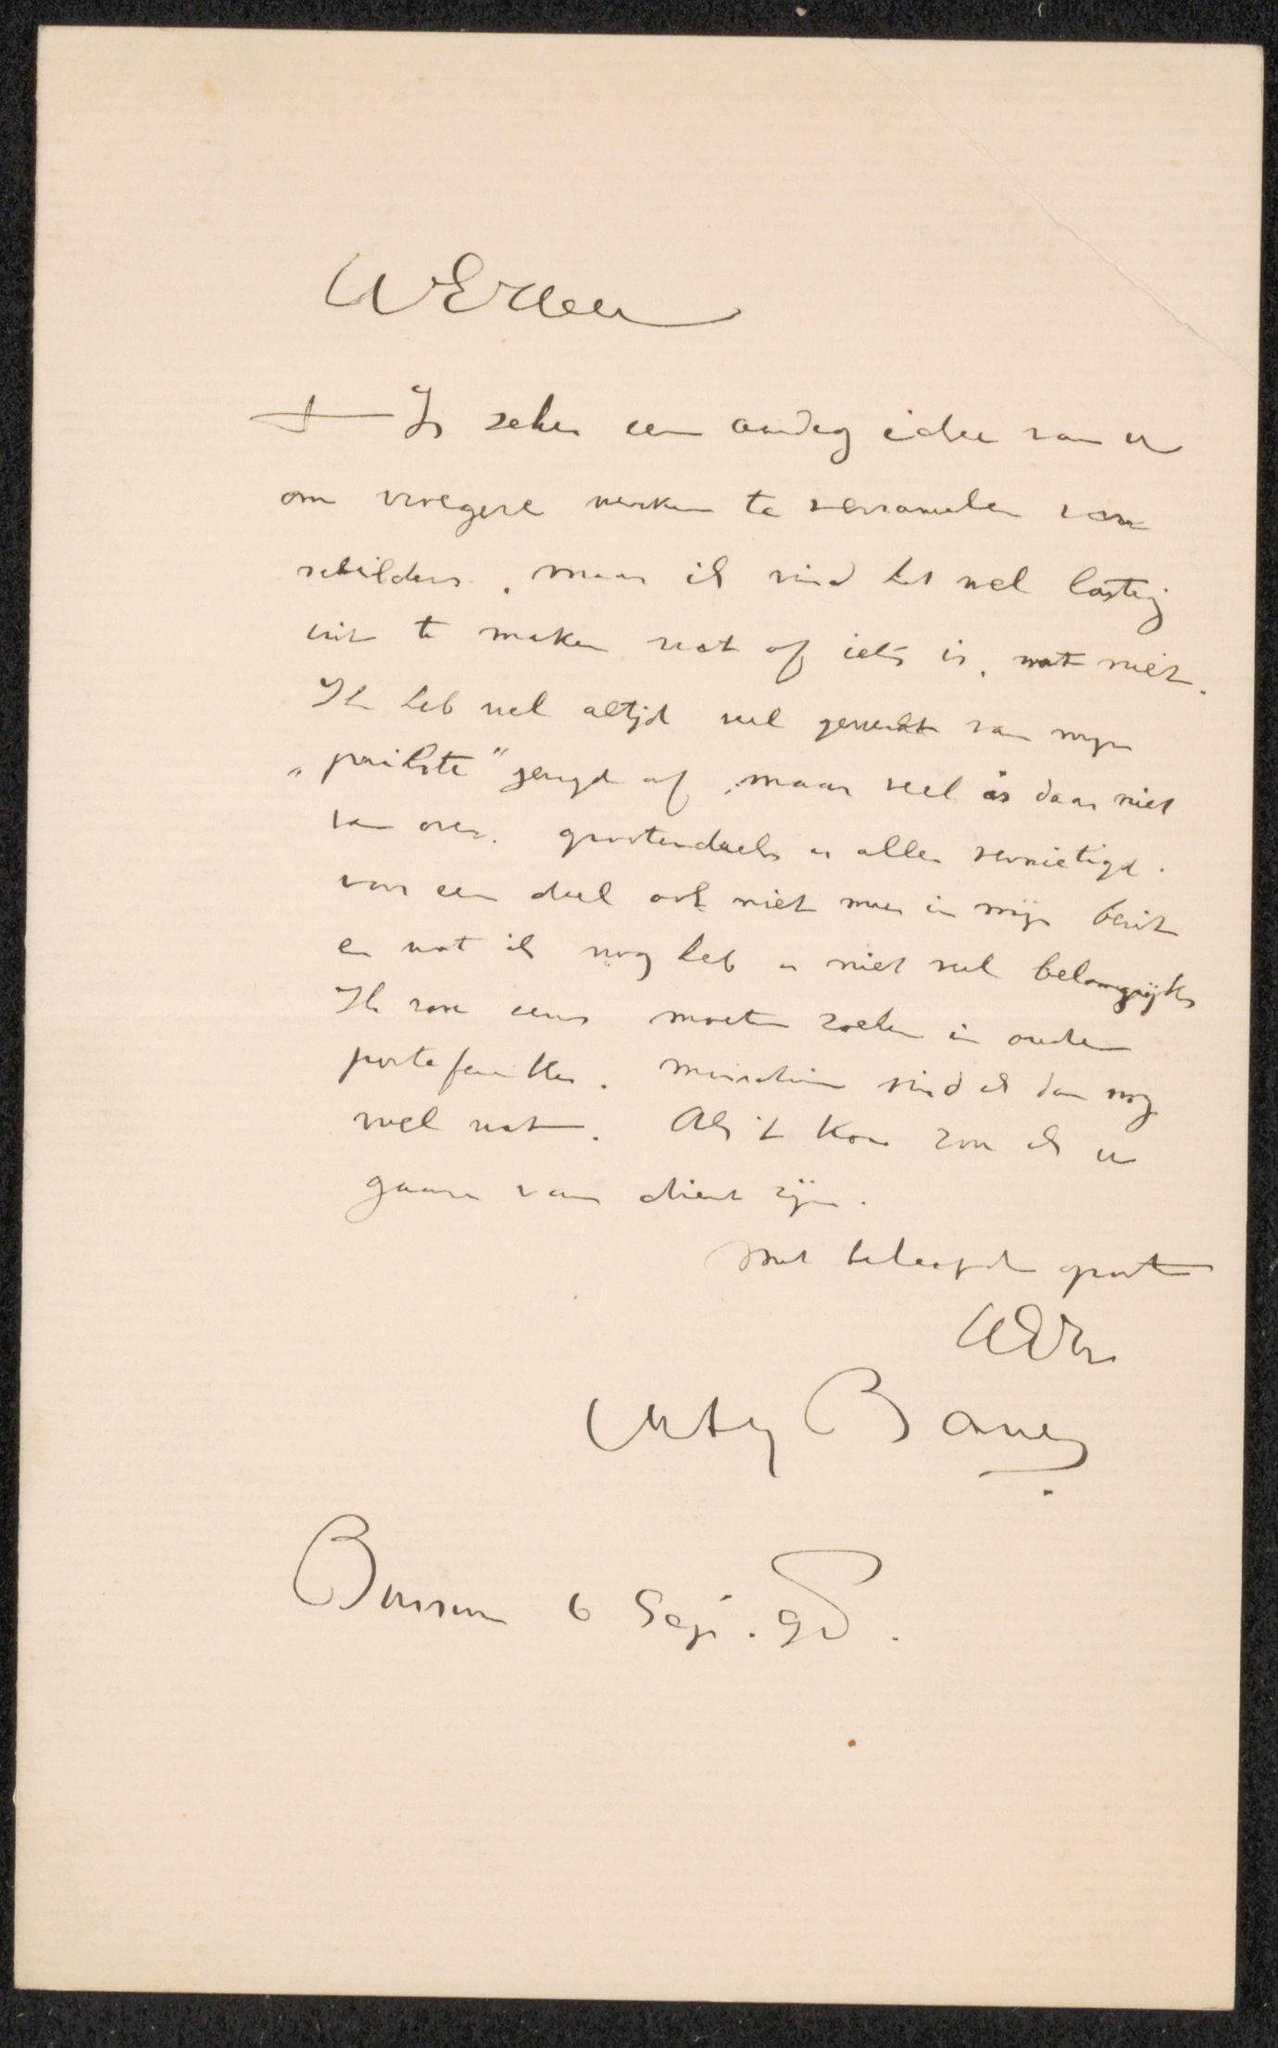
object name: letter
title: Brief aan Pieter Haverkorn van Rijsewijk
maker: marius bauer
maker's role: draughtsman, print maker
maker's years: 1867-1932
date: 1898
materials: ink, paper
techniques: pen, writing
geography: bussum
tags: pieter haverkorn van rijsewijk, art collecting